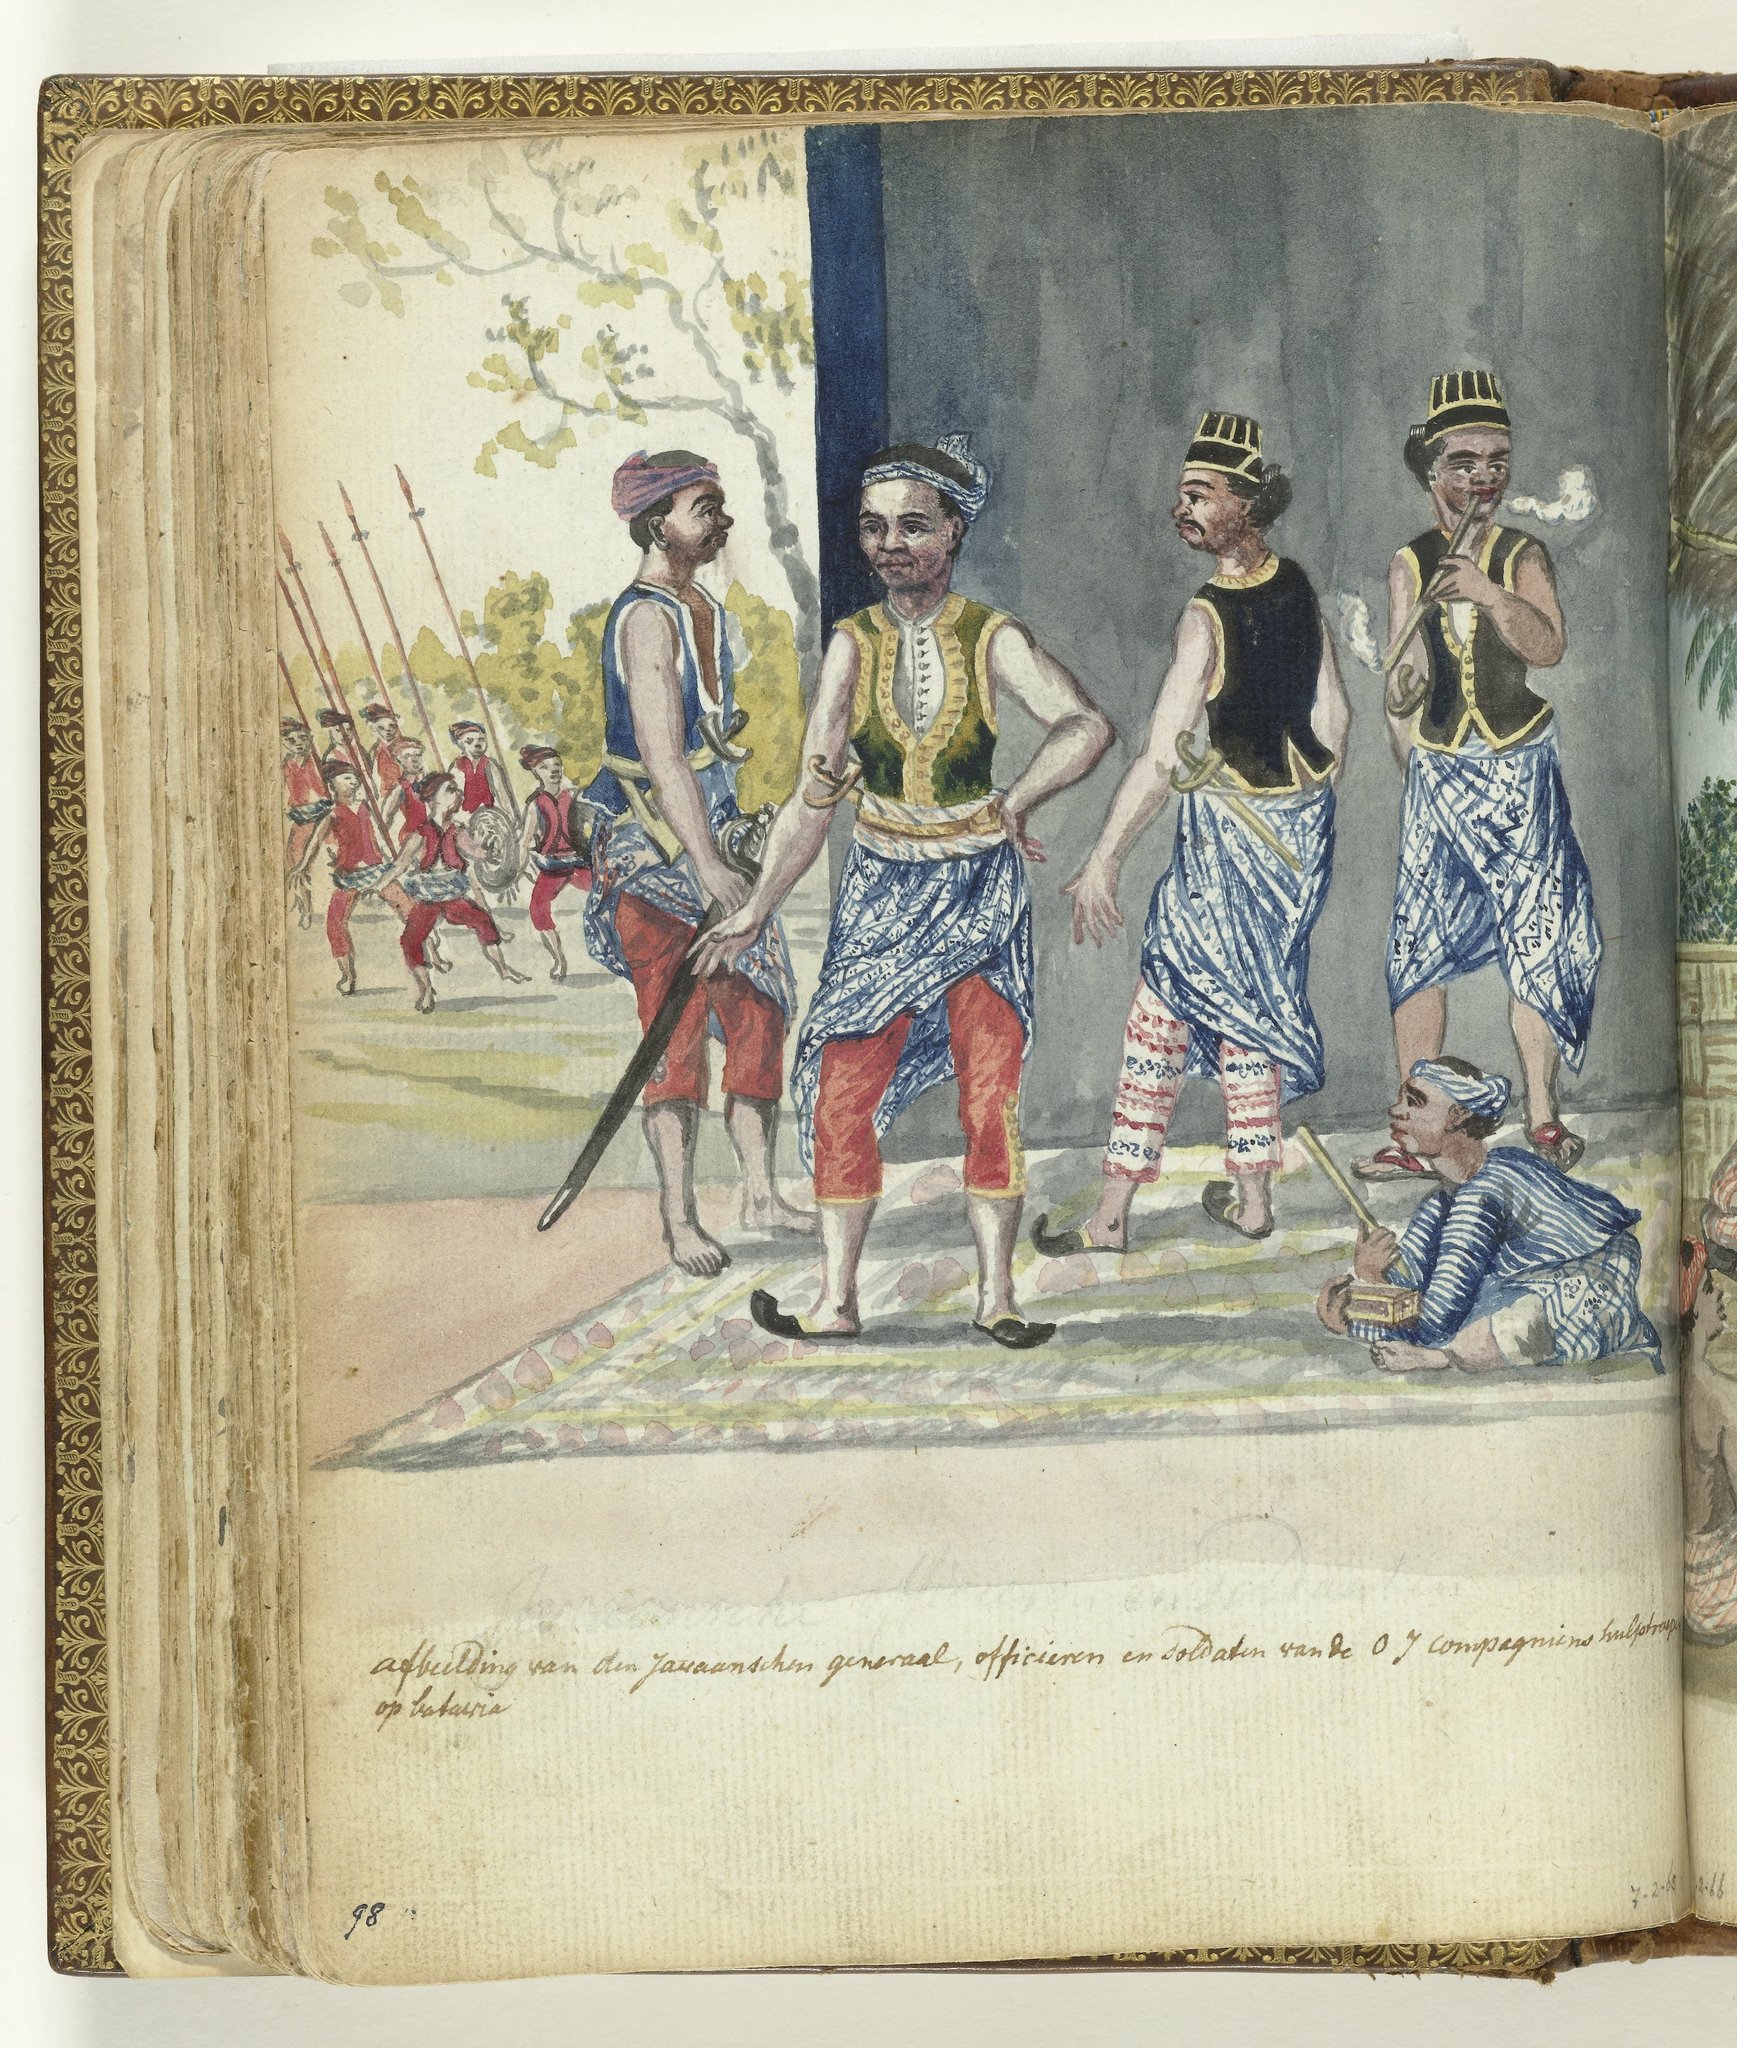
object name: drawing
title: Javaanse hulptroepen van de Compagnie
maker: jan brandes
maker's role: draughtsman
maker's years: 1743-1808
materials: paper, pencil, watercolor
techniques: brush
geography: jakarta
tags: warfare; military affairs (+ mercenary troops, e.g.: lansquenets), java, batavia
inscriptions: inscription: ‘afbeelding van den Javaanschen generaal, officieren en soldaten van de O I Compagniens hulptroepen op batavia’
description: Kleurtekening van op de voorgrond de generaal en de officieren en op de achtergrond de soldaten van de VOC-hulptroepen te Batavia. Met opschrift. Onderdeel uit het schetsboek van Jan Brandes, dl. 2 (1808), p. 98.